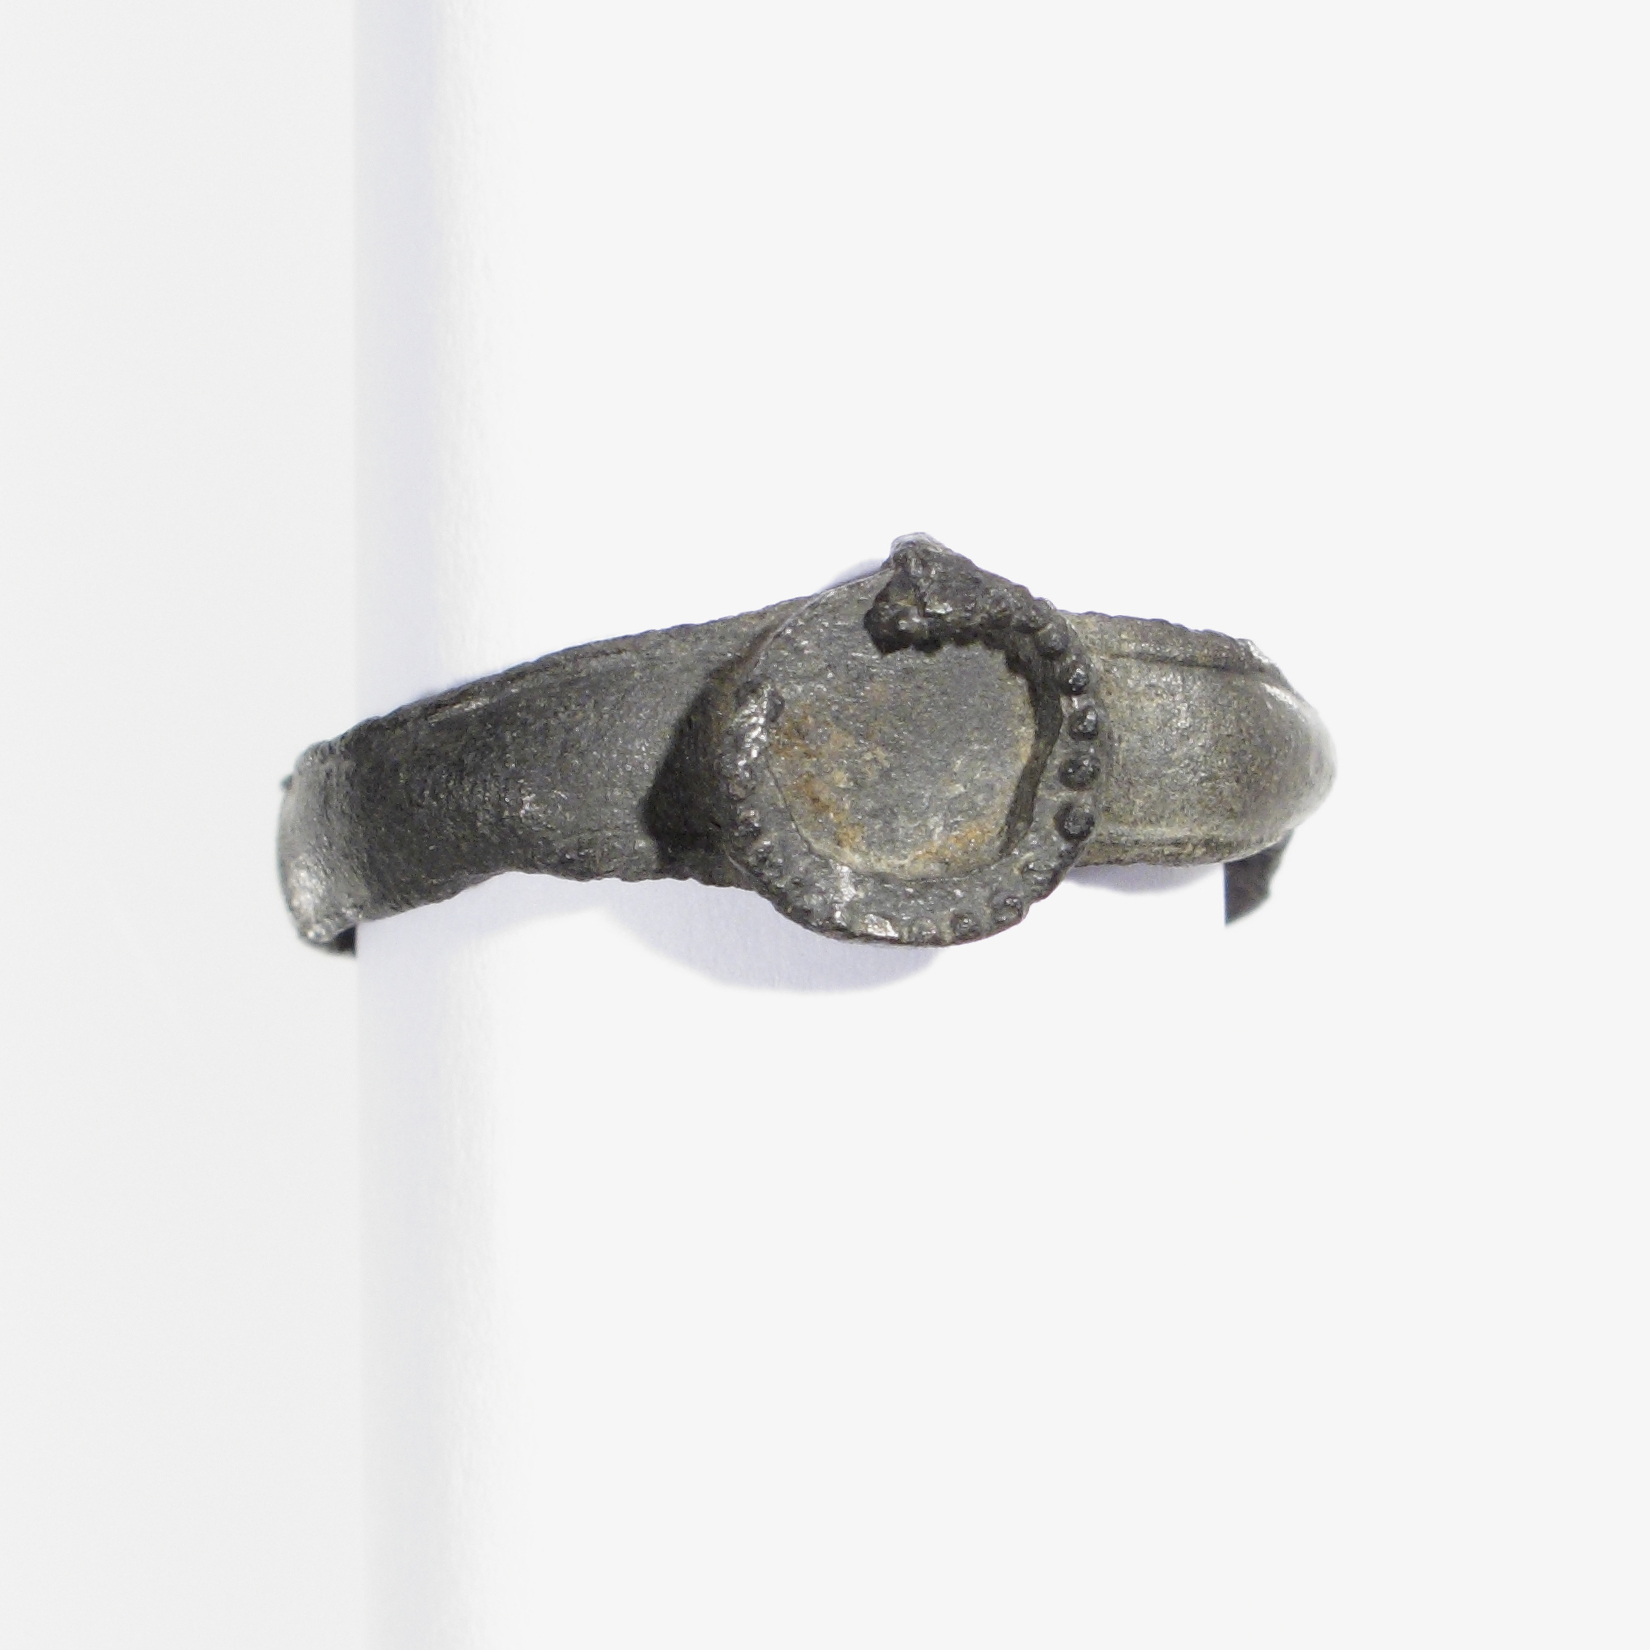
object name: pilgrim's badge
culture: french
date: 1301-1600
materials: lead